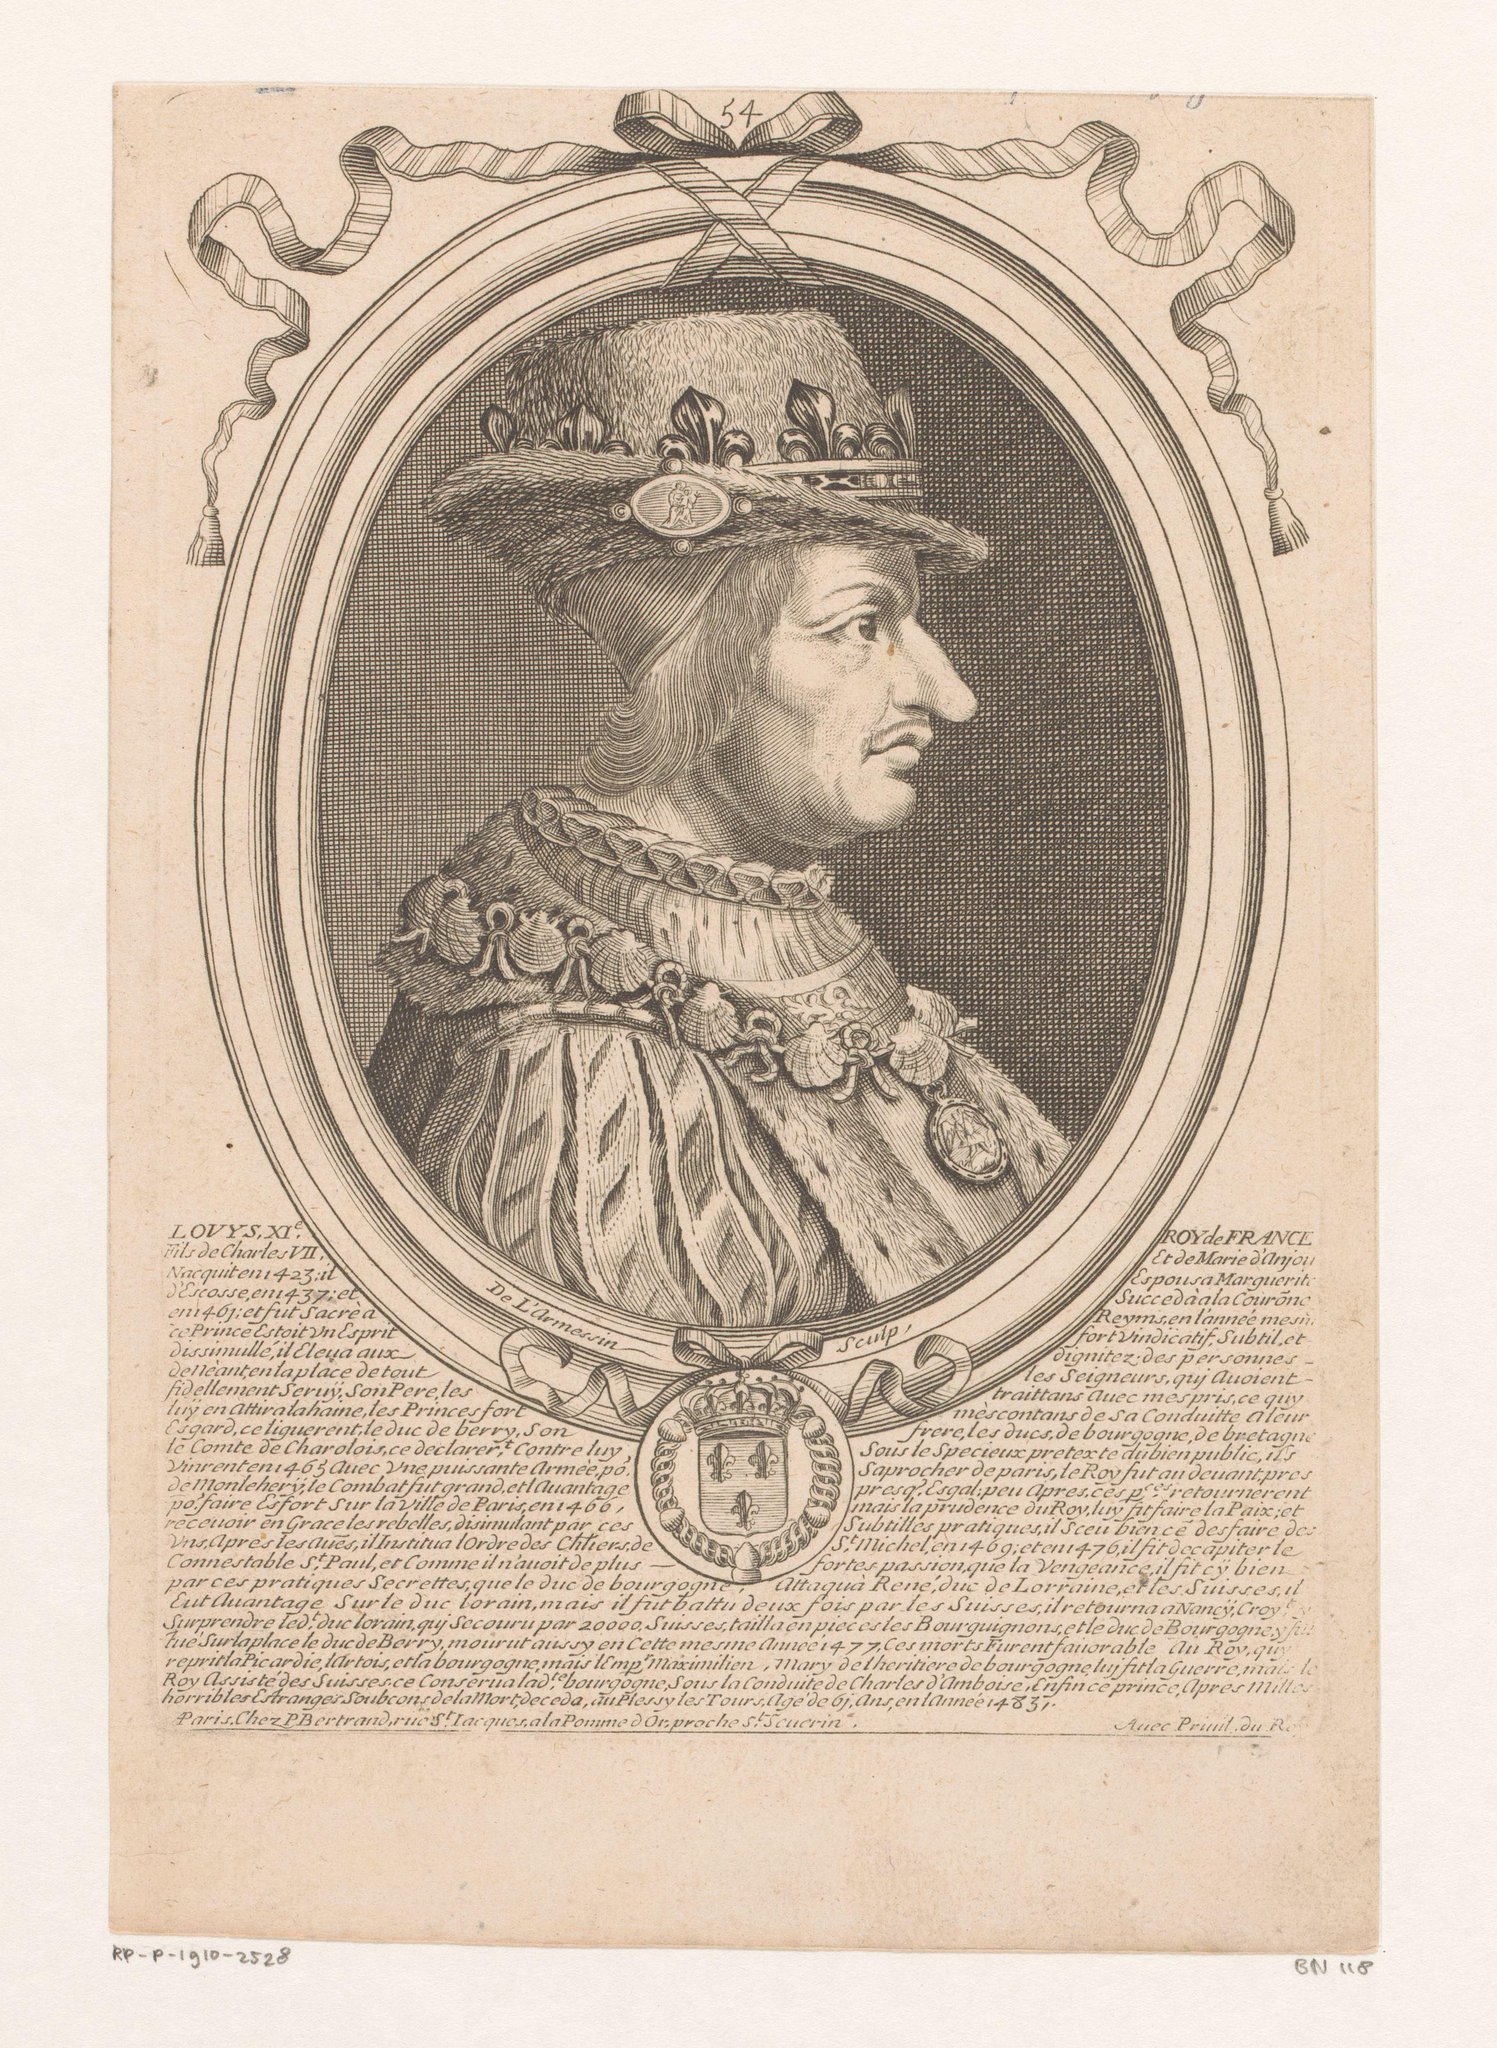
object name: print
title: Louys XI Roy de France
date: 1642-1678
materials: paper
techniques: engraving, etching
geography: france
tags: historical persons, king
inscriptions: collector's mark: Lugt 2228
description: Maakt deel uit van een grootschalige serie met portretten van prominente figuren. Binnen de serie bevindt zich een sectie getiteld 'Les Augustes Représentations De tous les Roys De France depuis Pharamond Iusqu'à Louys XIIII'. De serie werd respectievelijk uitgegeven door Pierre Bertrand, door zijn weduwe en door De Larmessin zelf.